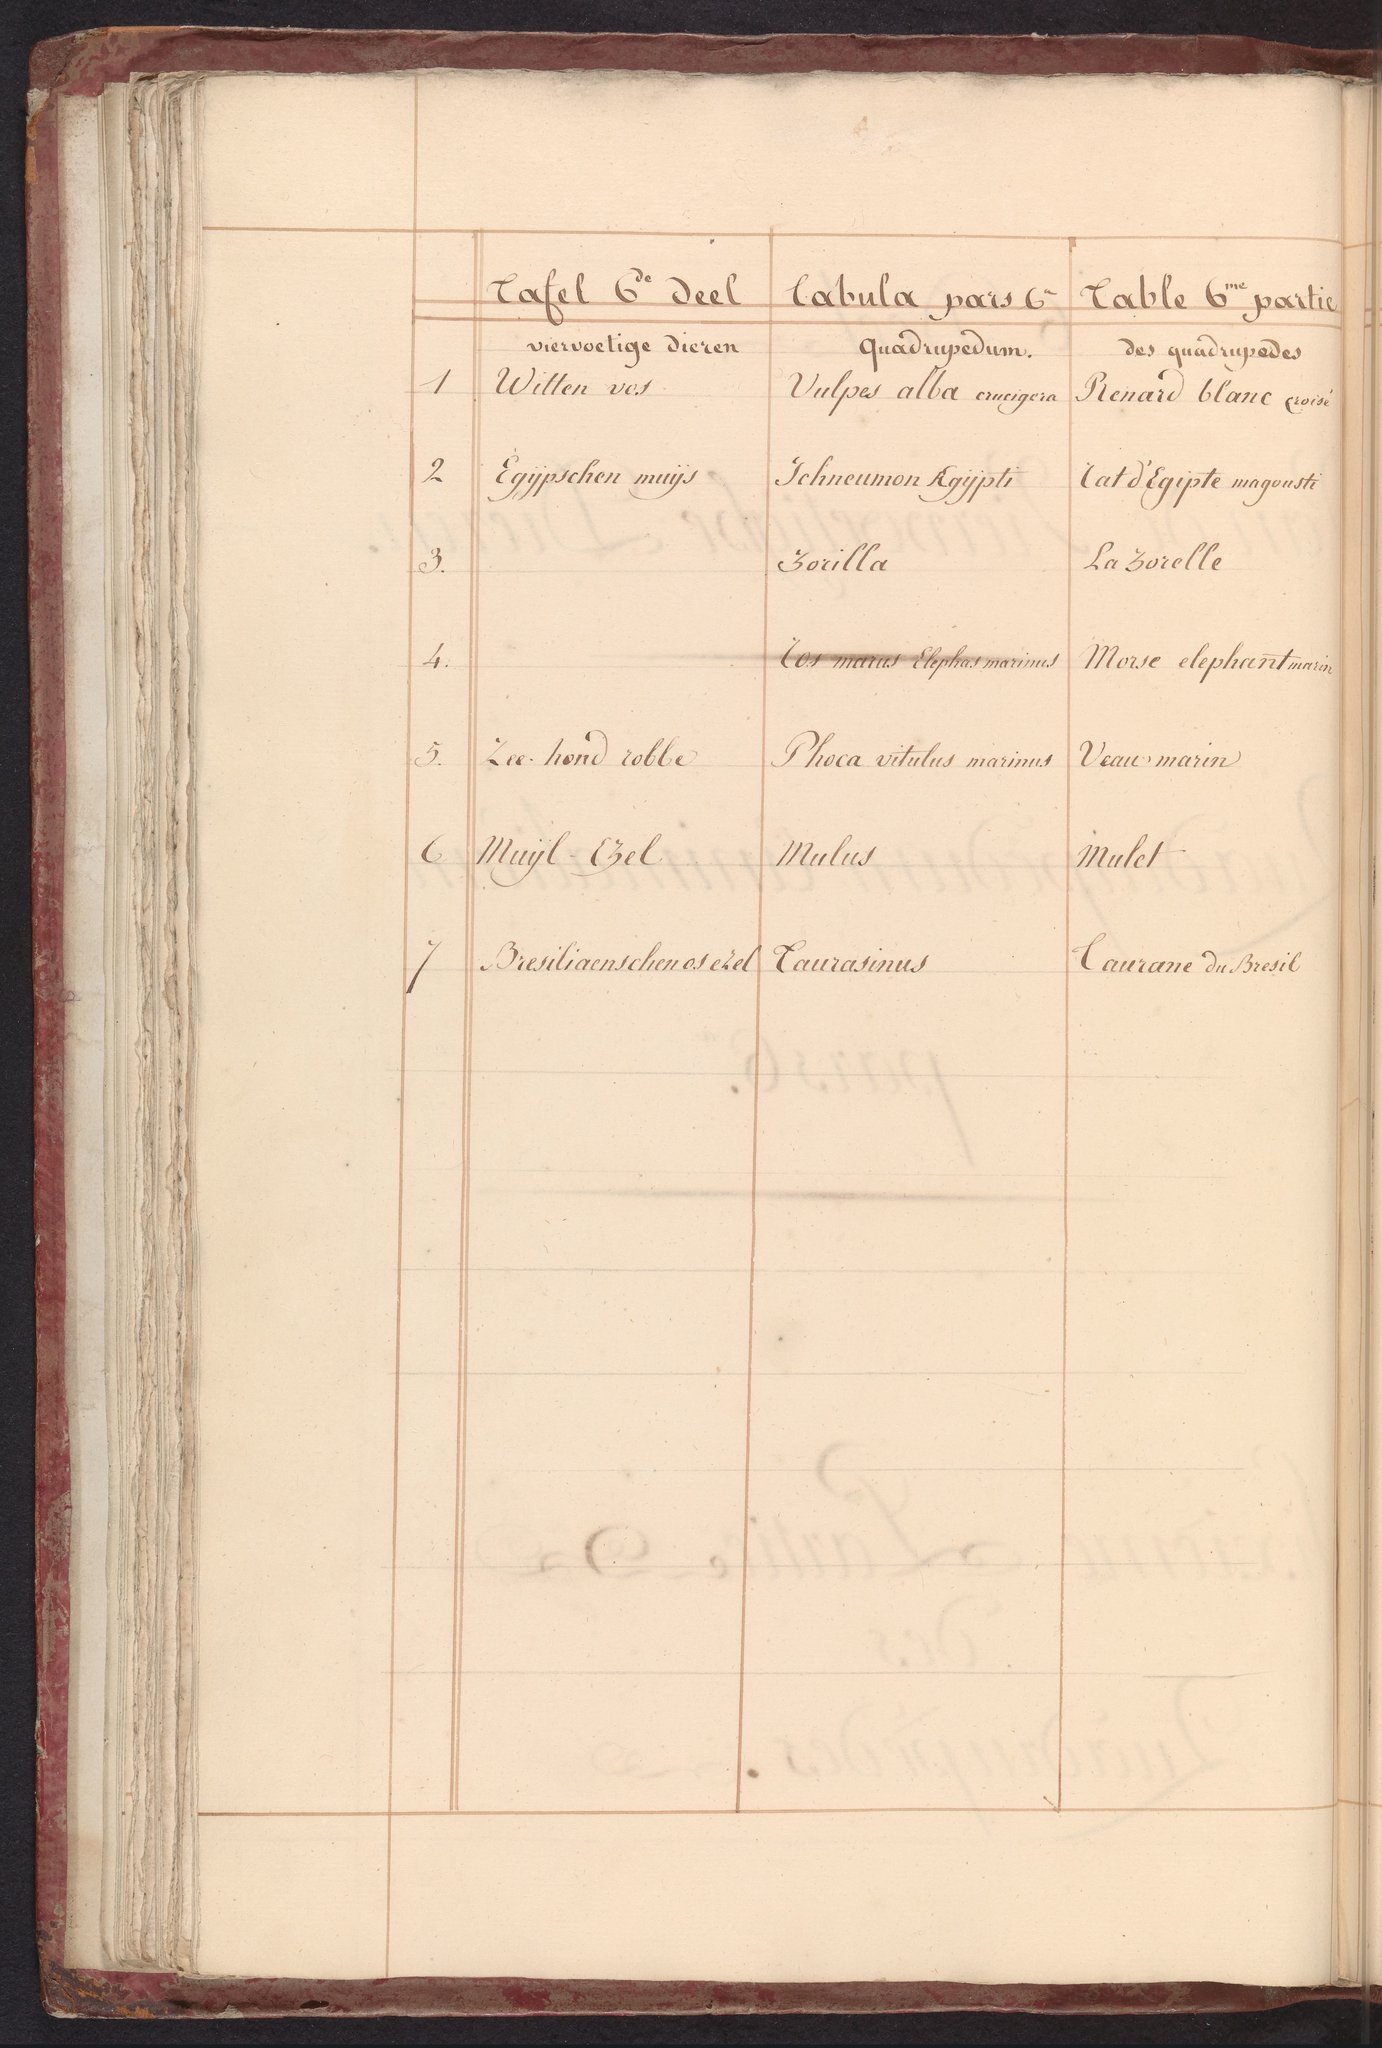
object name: manuscript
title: Lijst van dieren in zesde deel van de viervoeters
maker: joseph van huerne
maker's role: kunstliefhebber, mecenas, verzamelaar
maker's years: 1752-1844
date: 1809-1814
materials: ink, paper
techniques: handwriting, pen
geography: bruges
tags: handwriting, written text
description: Schema met een lijst van dieren voorgesteld in het zesde deel van de viervoeters: nummers 1-7. Onderdeel van het tweede album met tekeningen van viervoeters. Tweede van twaalf albums met tekeningen van dieren, vogels en planten bekend rond 1600, gemaakt in opdracht van keizer Rudolf II. Met toelichting in Nederlands, Latijn en Frans.